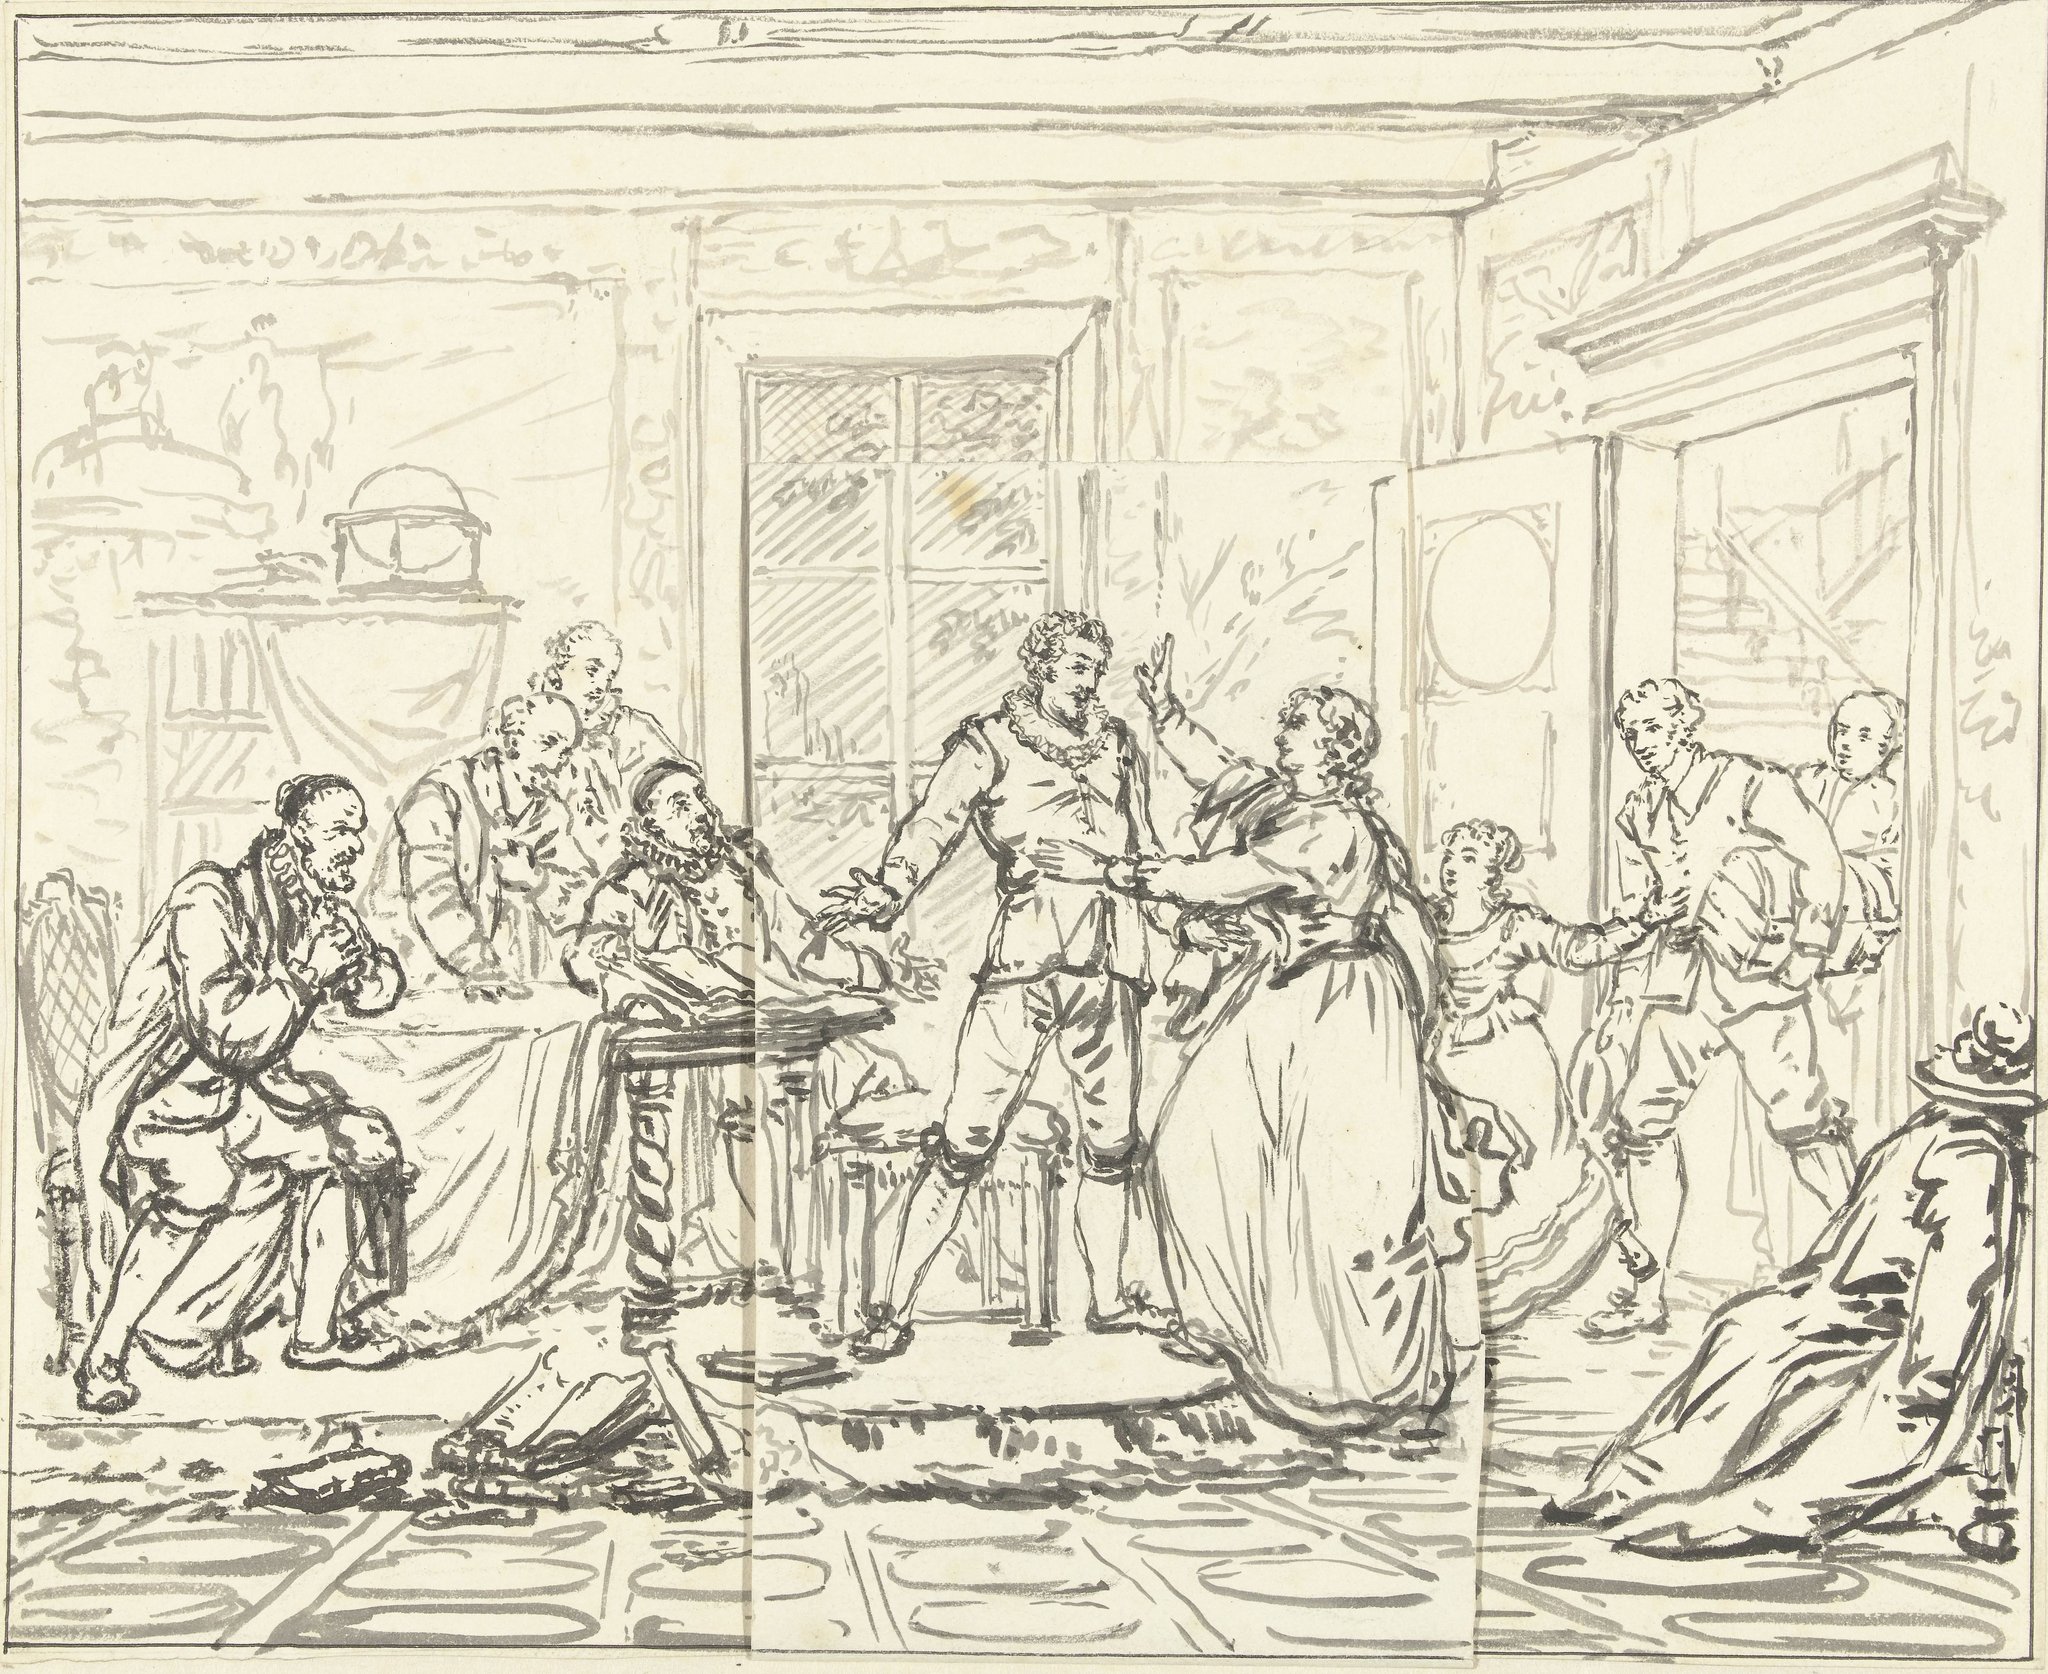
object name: drawing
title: Toneelscène uit Jacob Simonsz de Rijk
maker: pieter bartholomeusz. barbiers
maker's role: draughtsman, print maker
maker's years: 1772-1837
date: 1782-1837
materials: paper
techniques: brush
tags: (scenes from) specific works of literature (with author, title), group of actors, troupe; actors on the stage